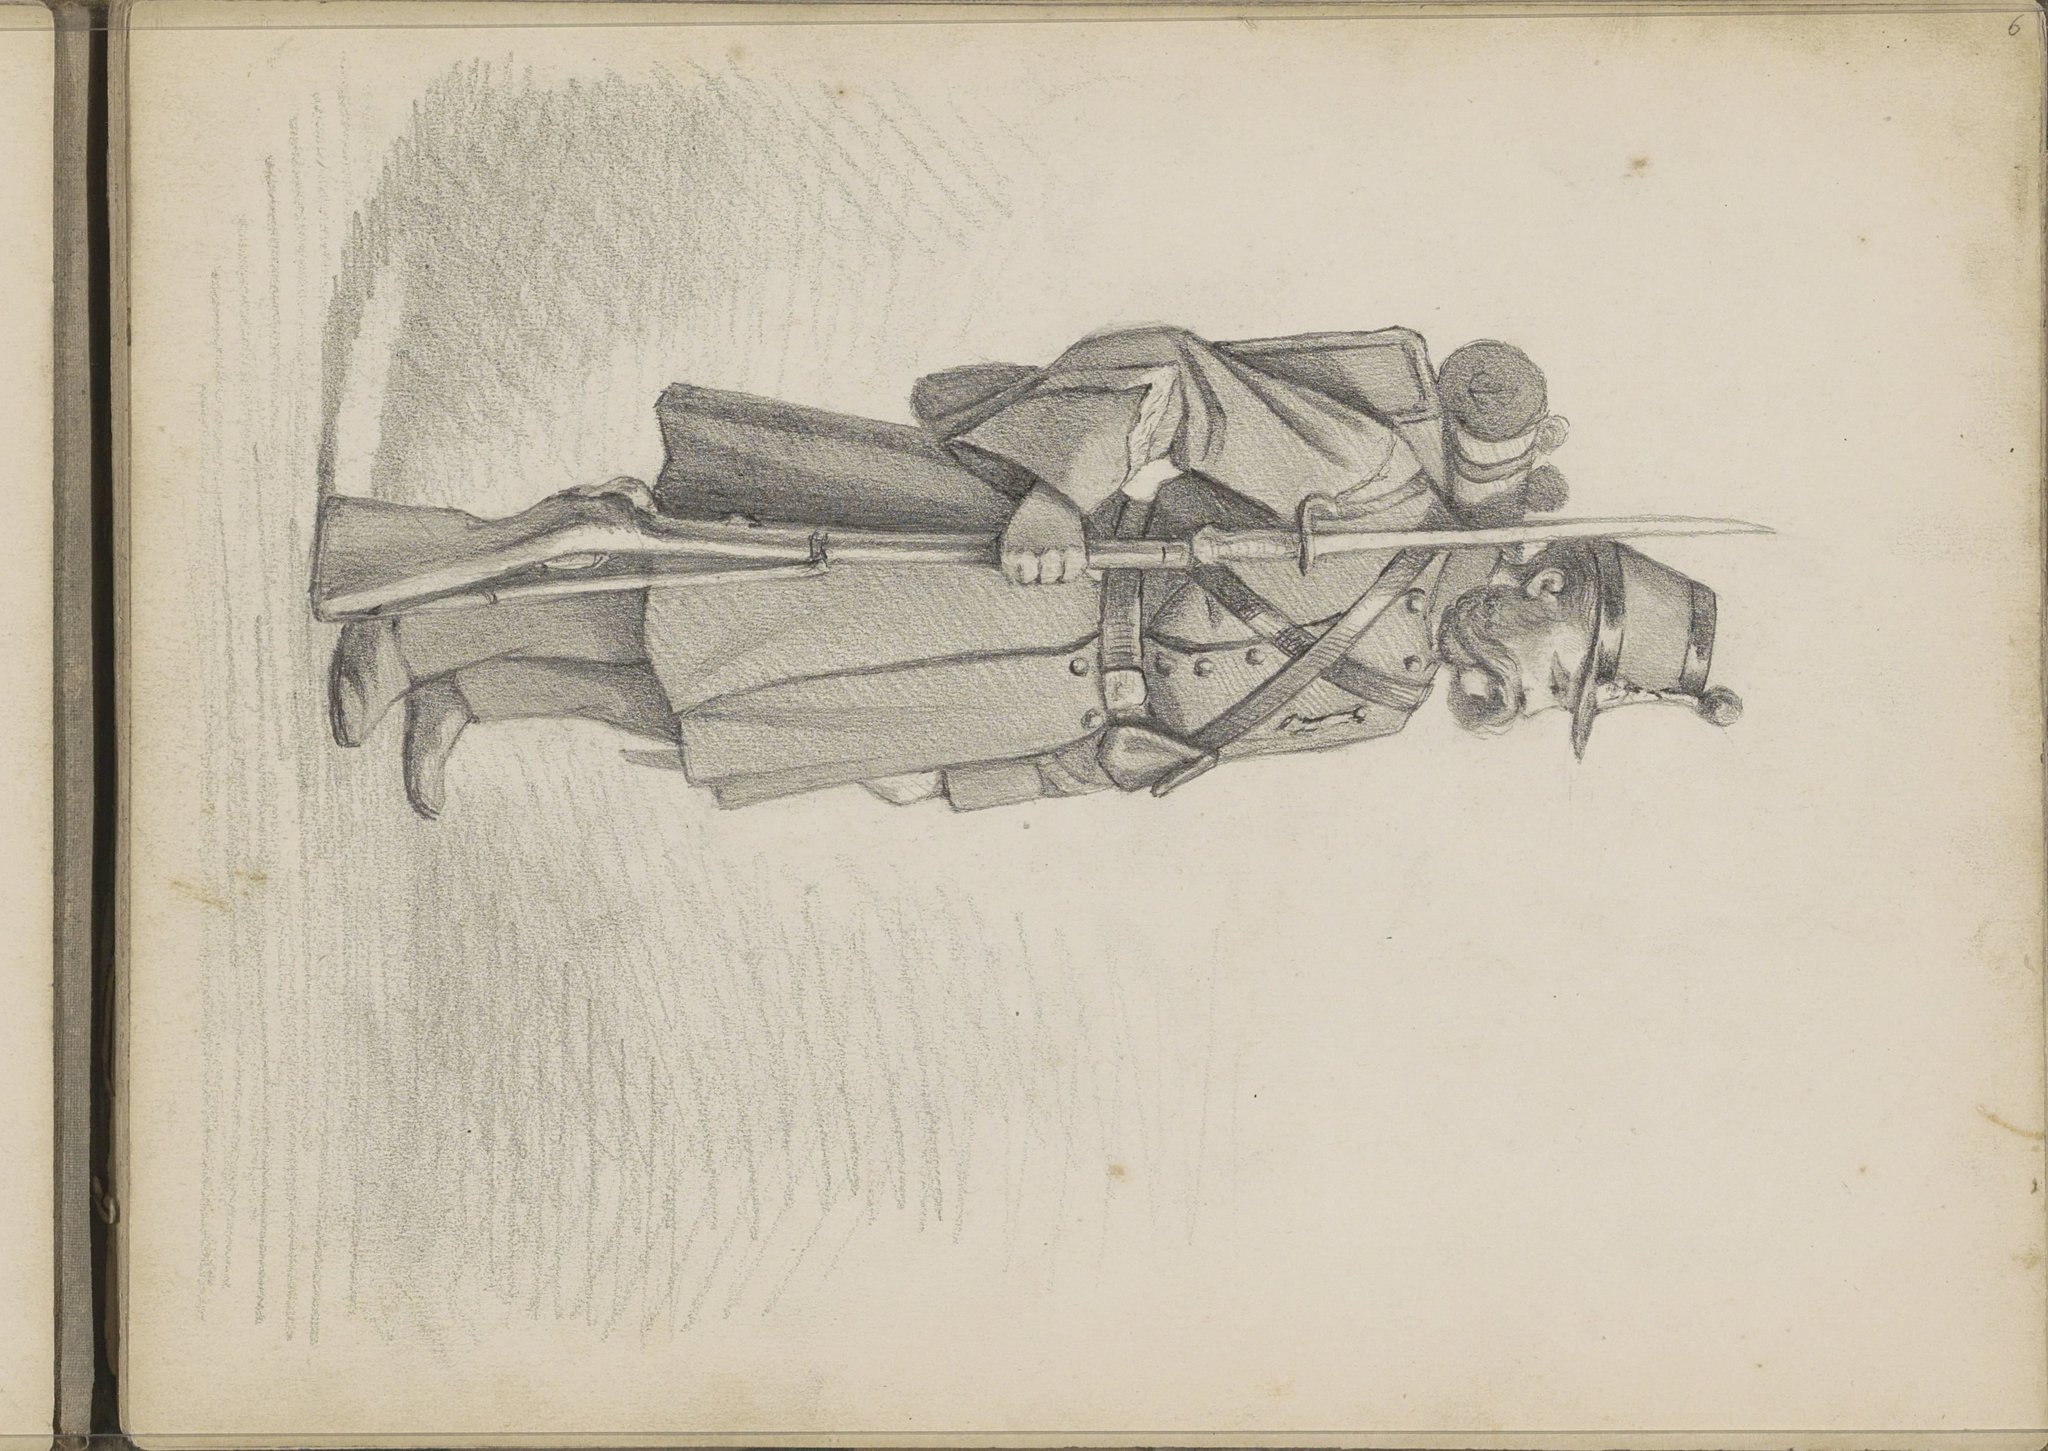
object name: sketchbook leaf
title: Soldaat met geweer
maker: willem cornelis rip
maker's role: draughtsman, painter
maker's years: 1856-1922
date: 1874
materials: paper, pencil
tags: firearms: rifle, the soldier; the soldier's life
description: Blad 6 recto uit een schetsboek met 27 losse bladen.